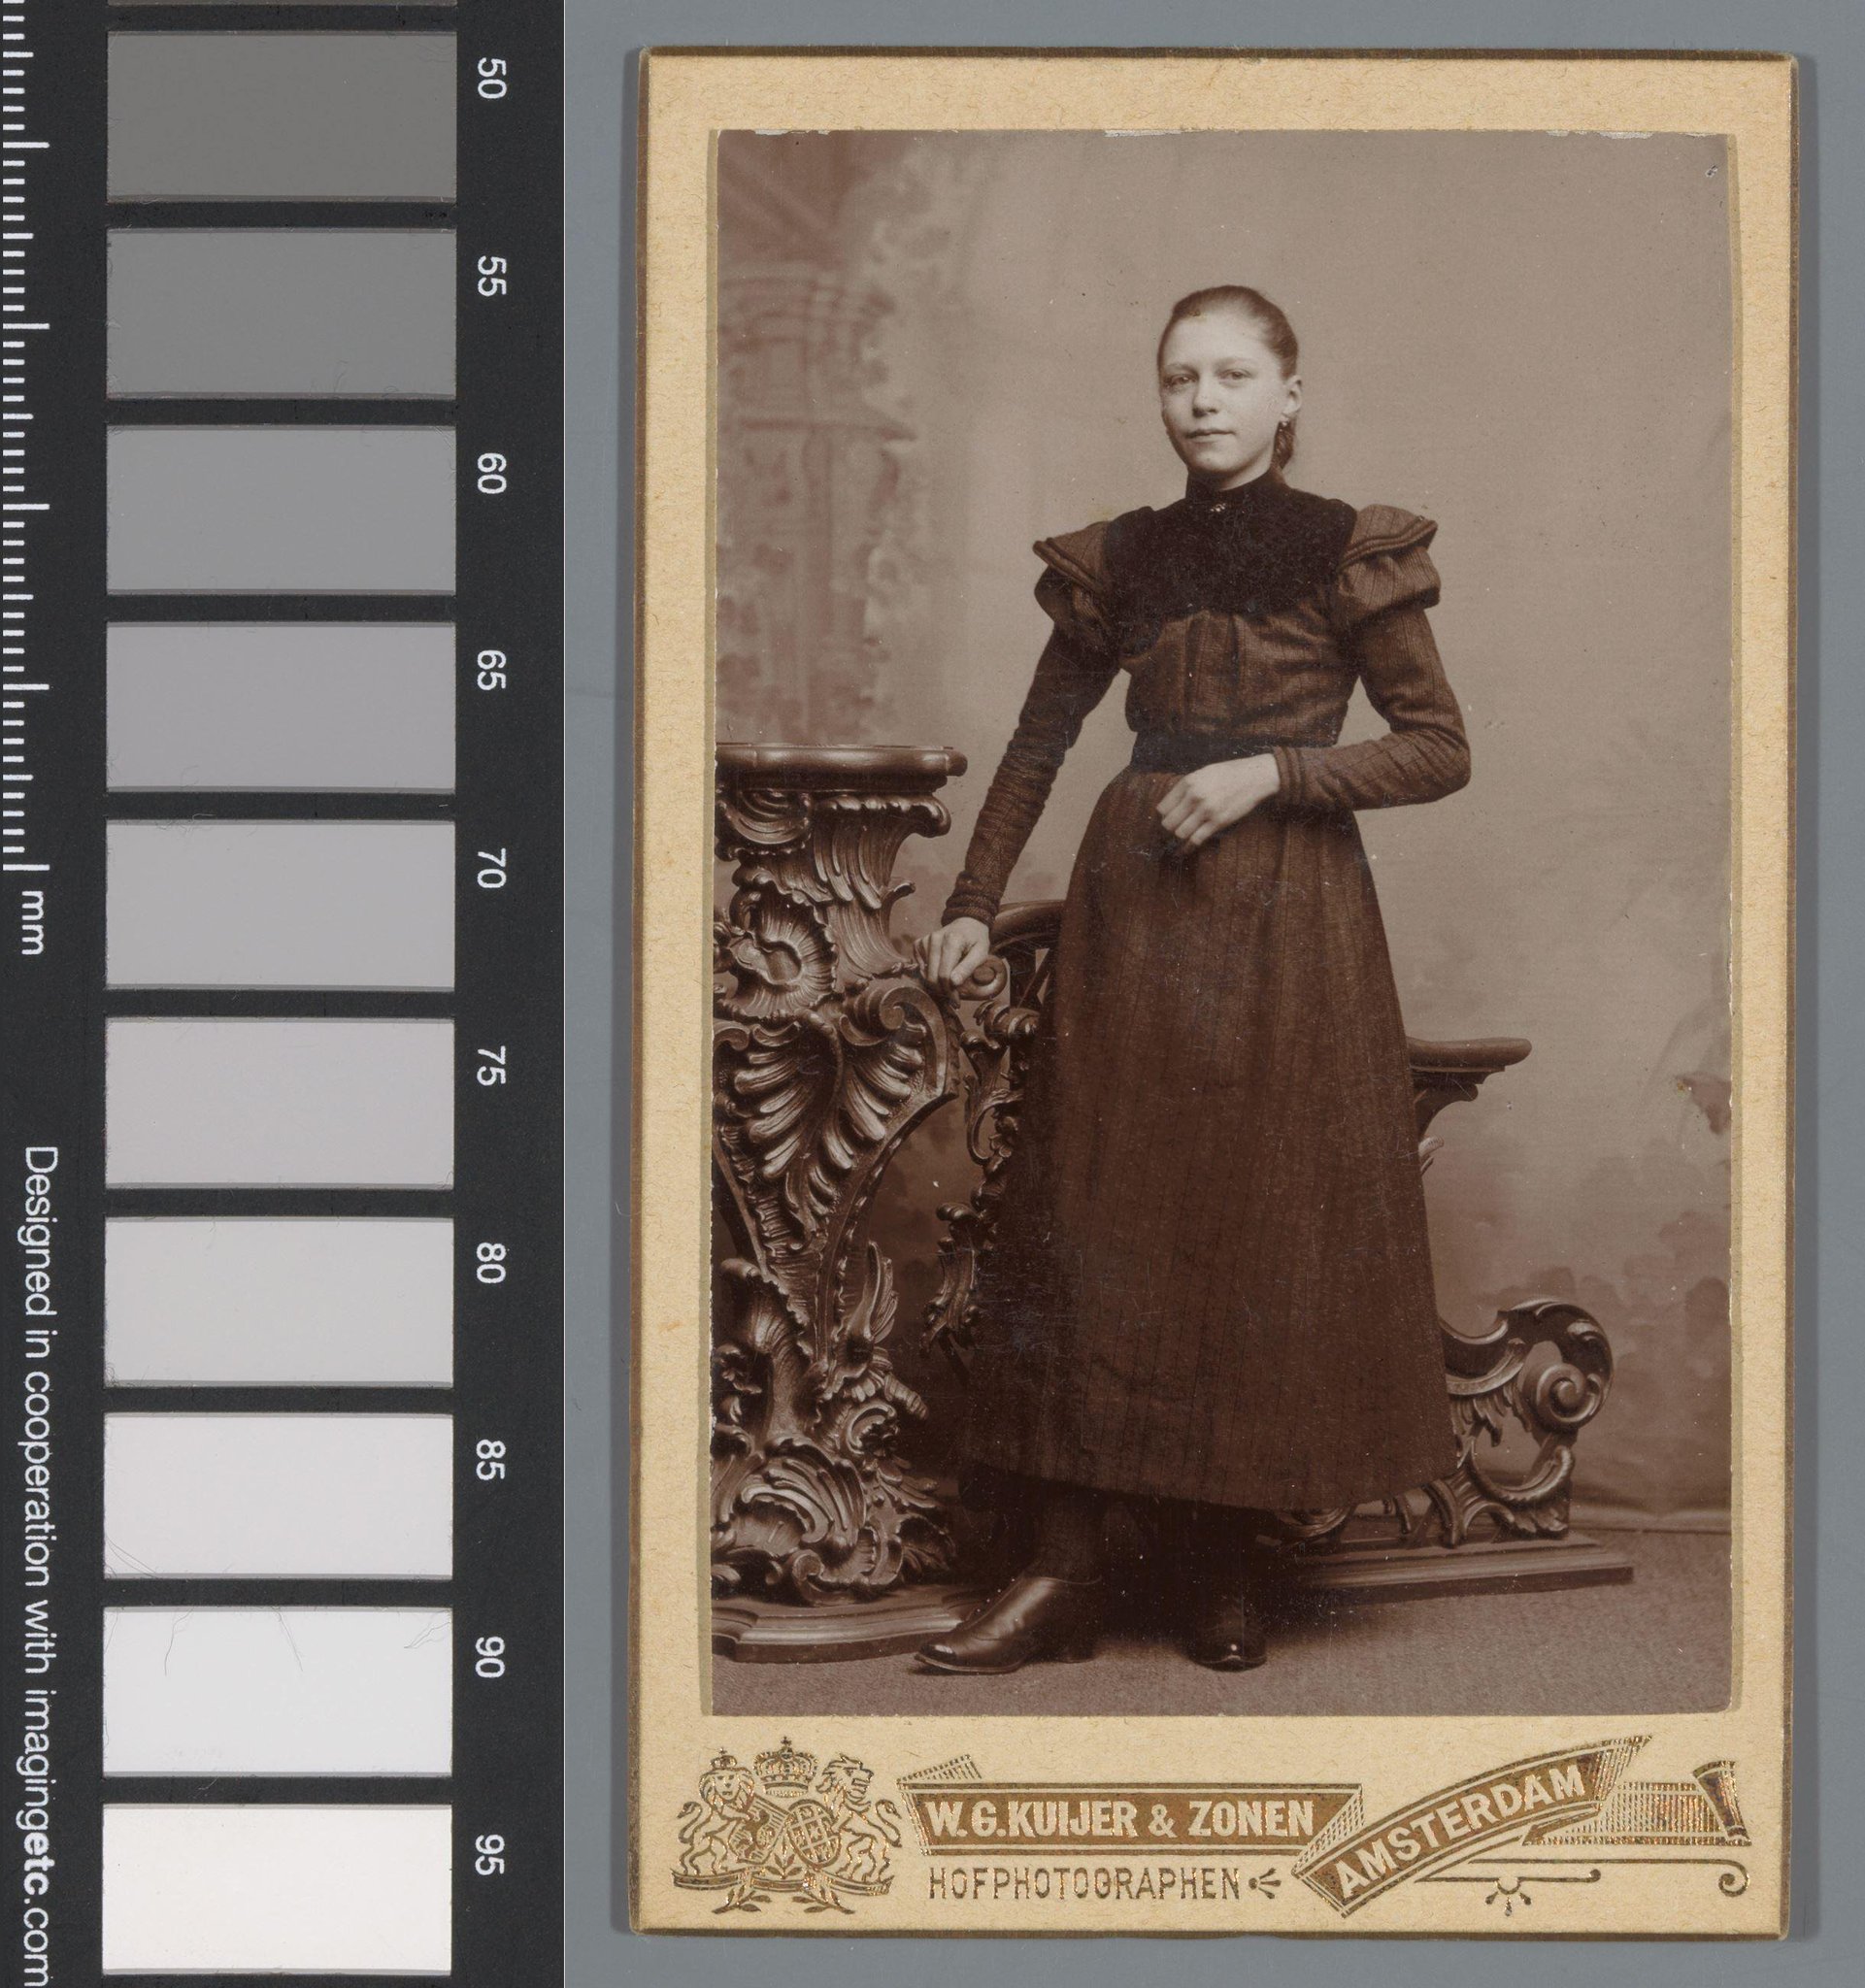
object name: carte de visite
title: Portret van een onbekende vrouw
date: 1885-1906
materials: cardboard, photographic support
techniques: daylight paper print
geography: amsterdam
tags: adolescent, young woman, maiden, historical persons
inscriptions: inscription: ‘OPGERICHT 1864/ AMSTERDAM/ Wester markt. 19/ W. G. KUIJER & ZONEN/ HOFPHOTOGRAPHEN/ Spéciale Inrichting/ voor/ VERGROOTINGEN/ in alle Formaten/ B.P. GRIMAUD PARIS.’